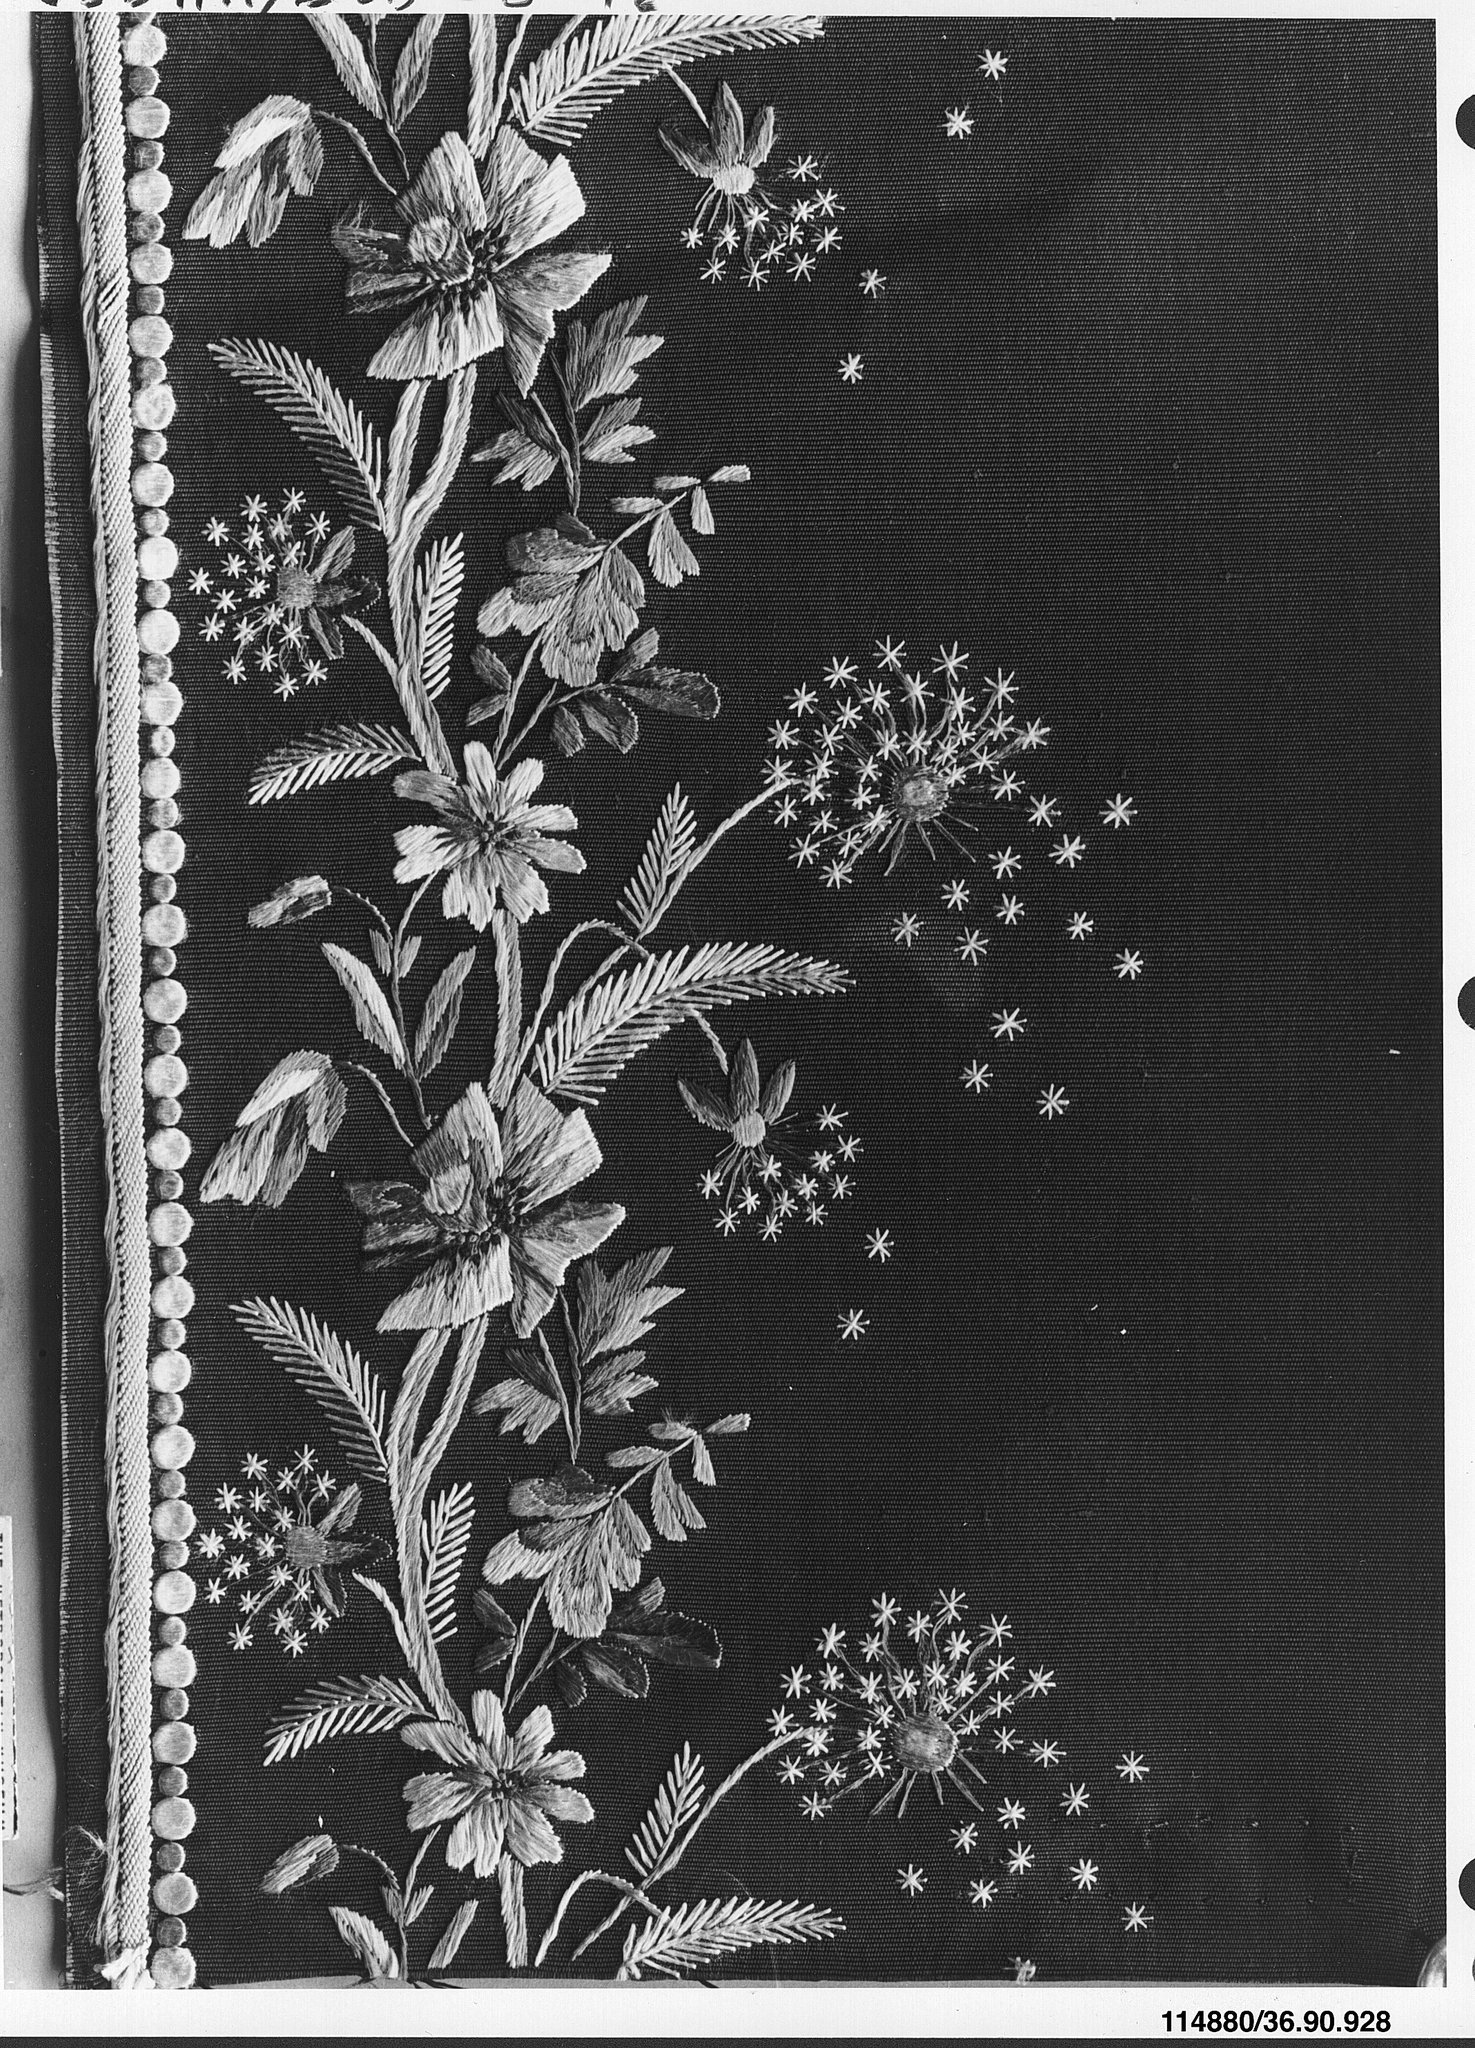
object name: sample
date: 1801-1833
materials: silk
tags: flowers